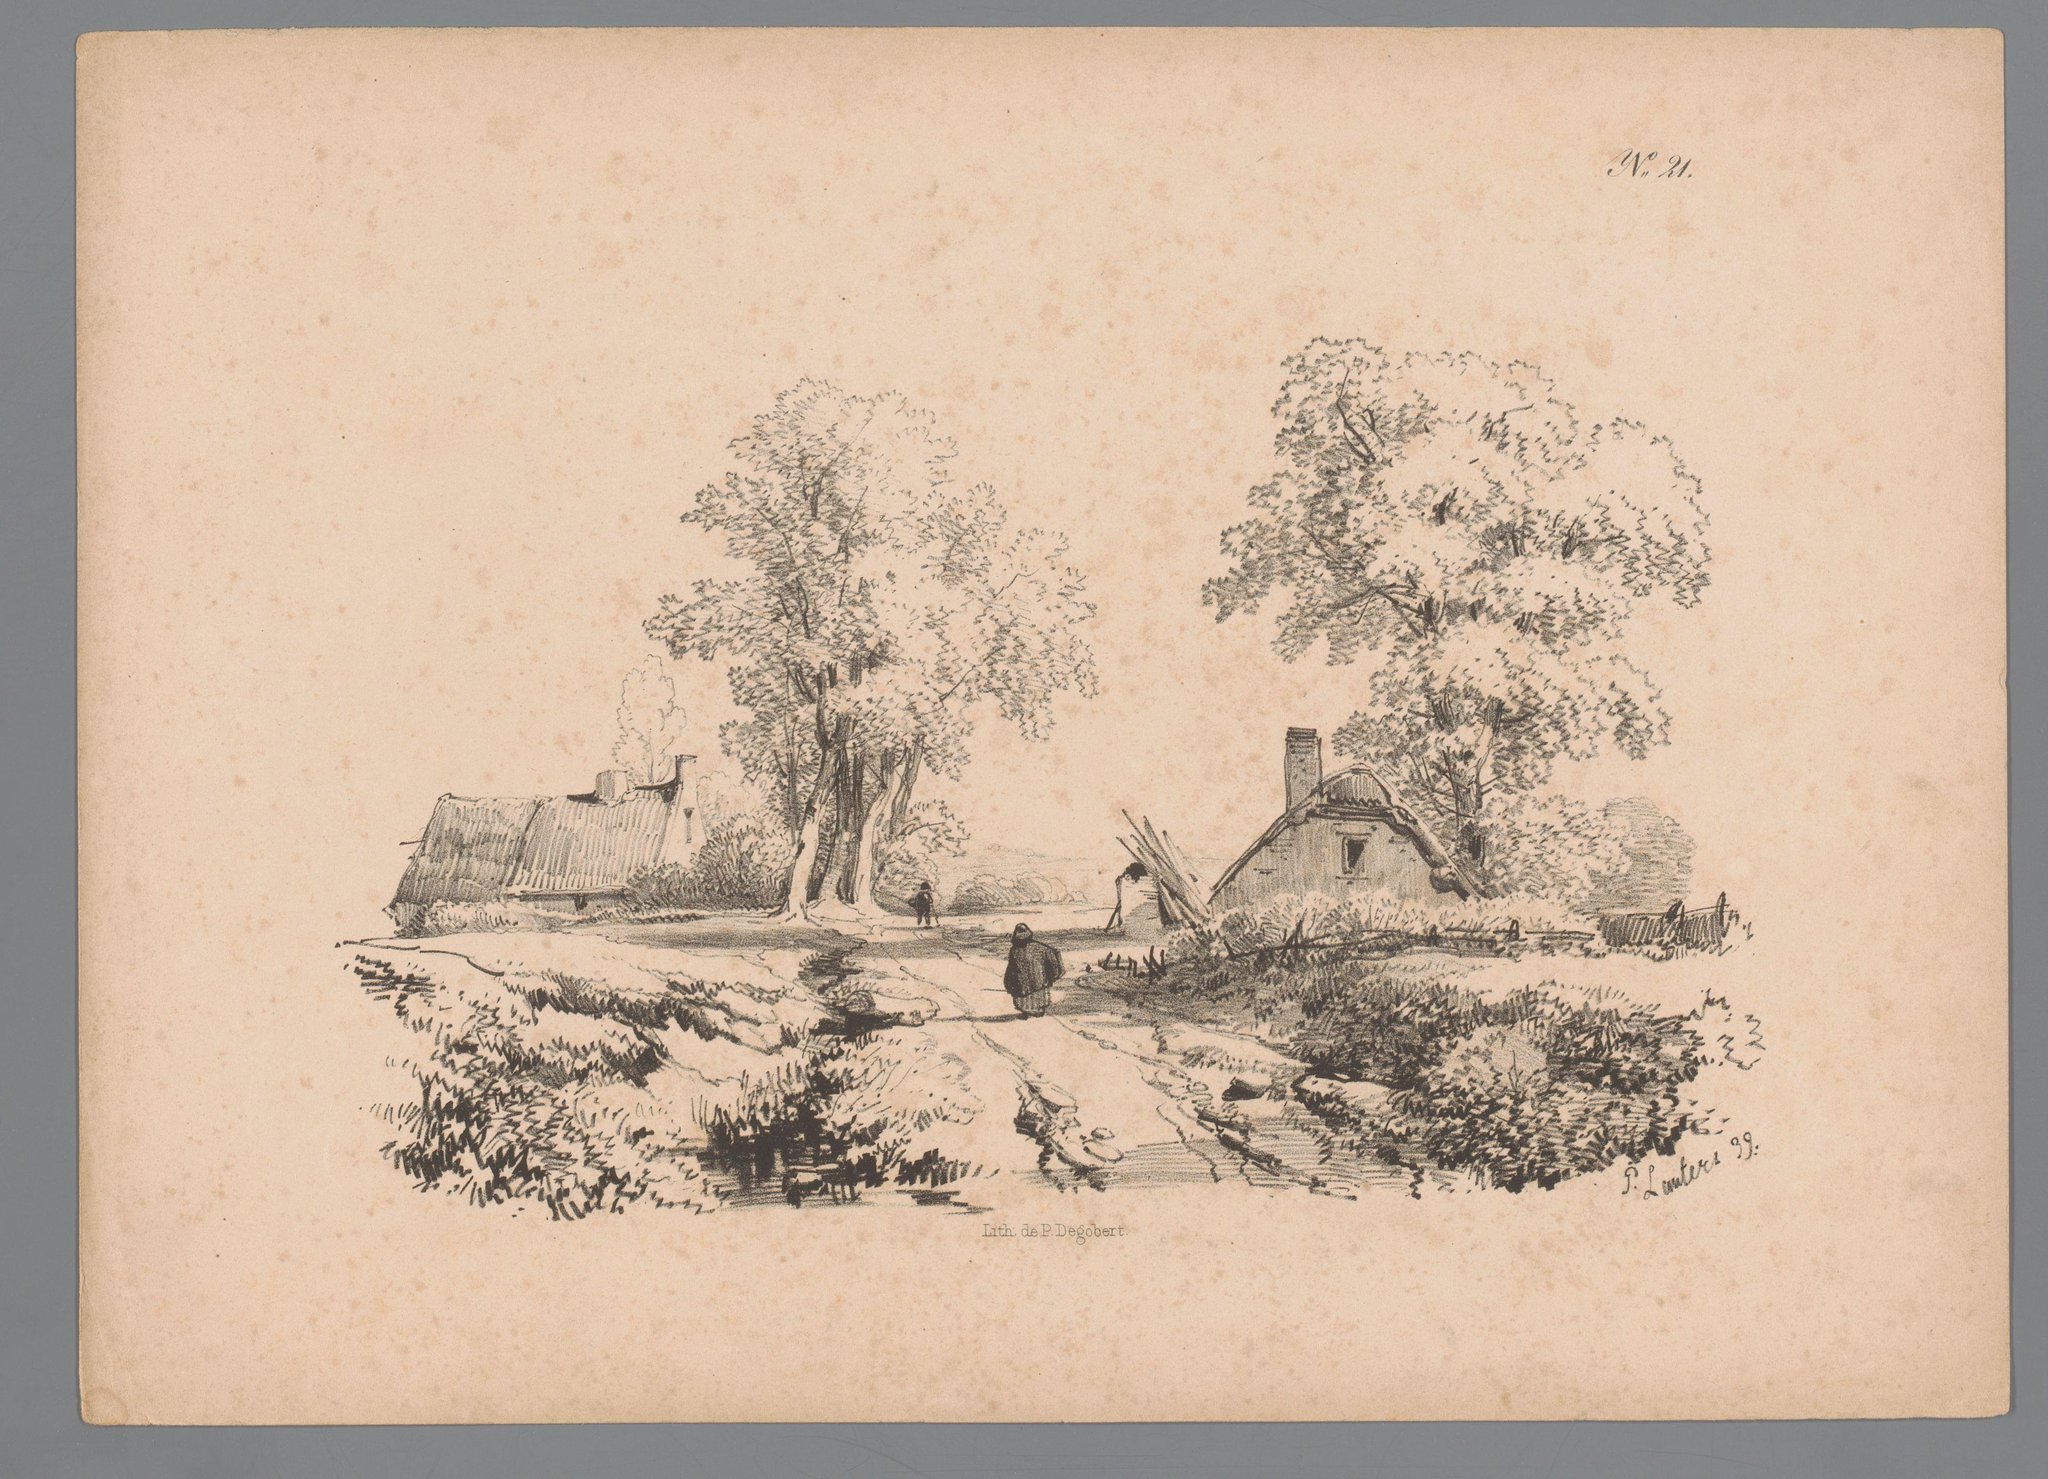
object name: print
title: Landschap met twee huizen en twee figuren op een weg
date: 1839-1840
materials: paper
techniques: lithograph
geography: brussels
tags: road, path, landscapes (+ landscape with figures, staffage)